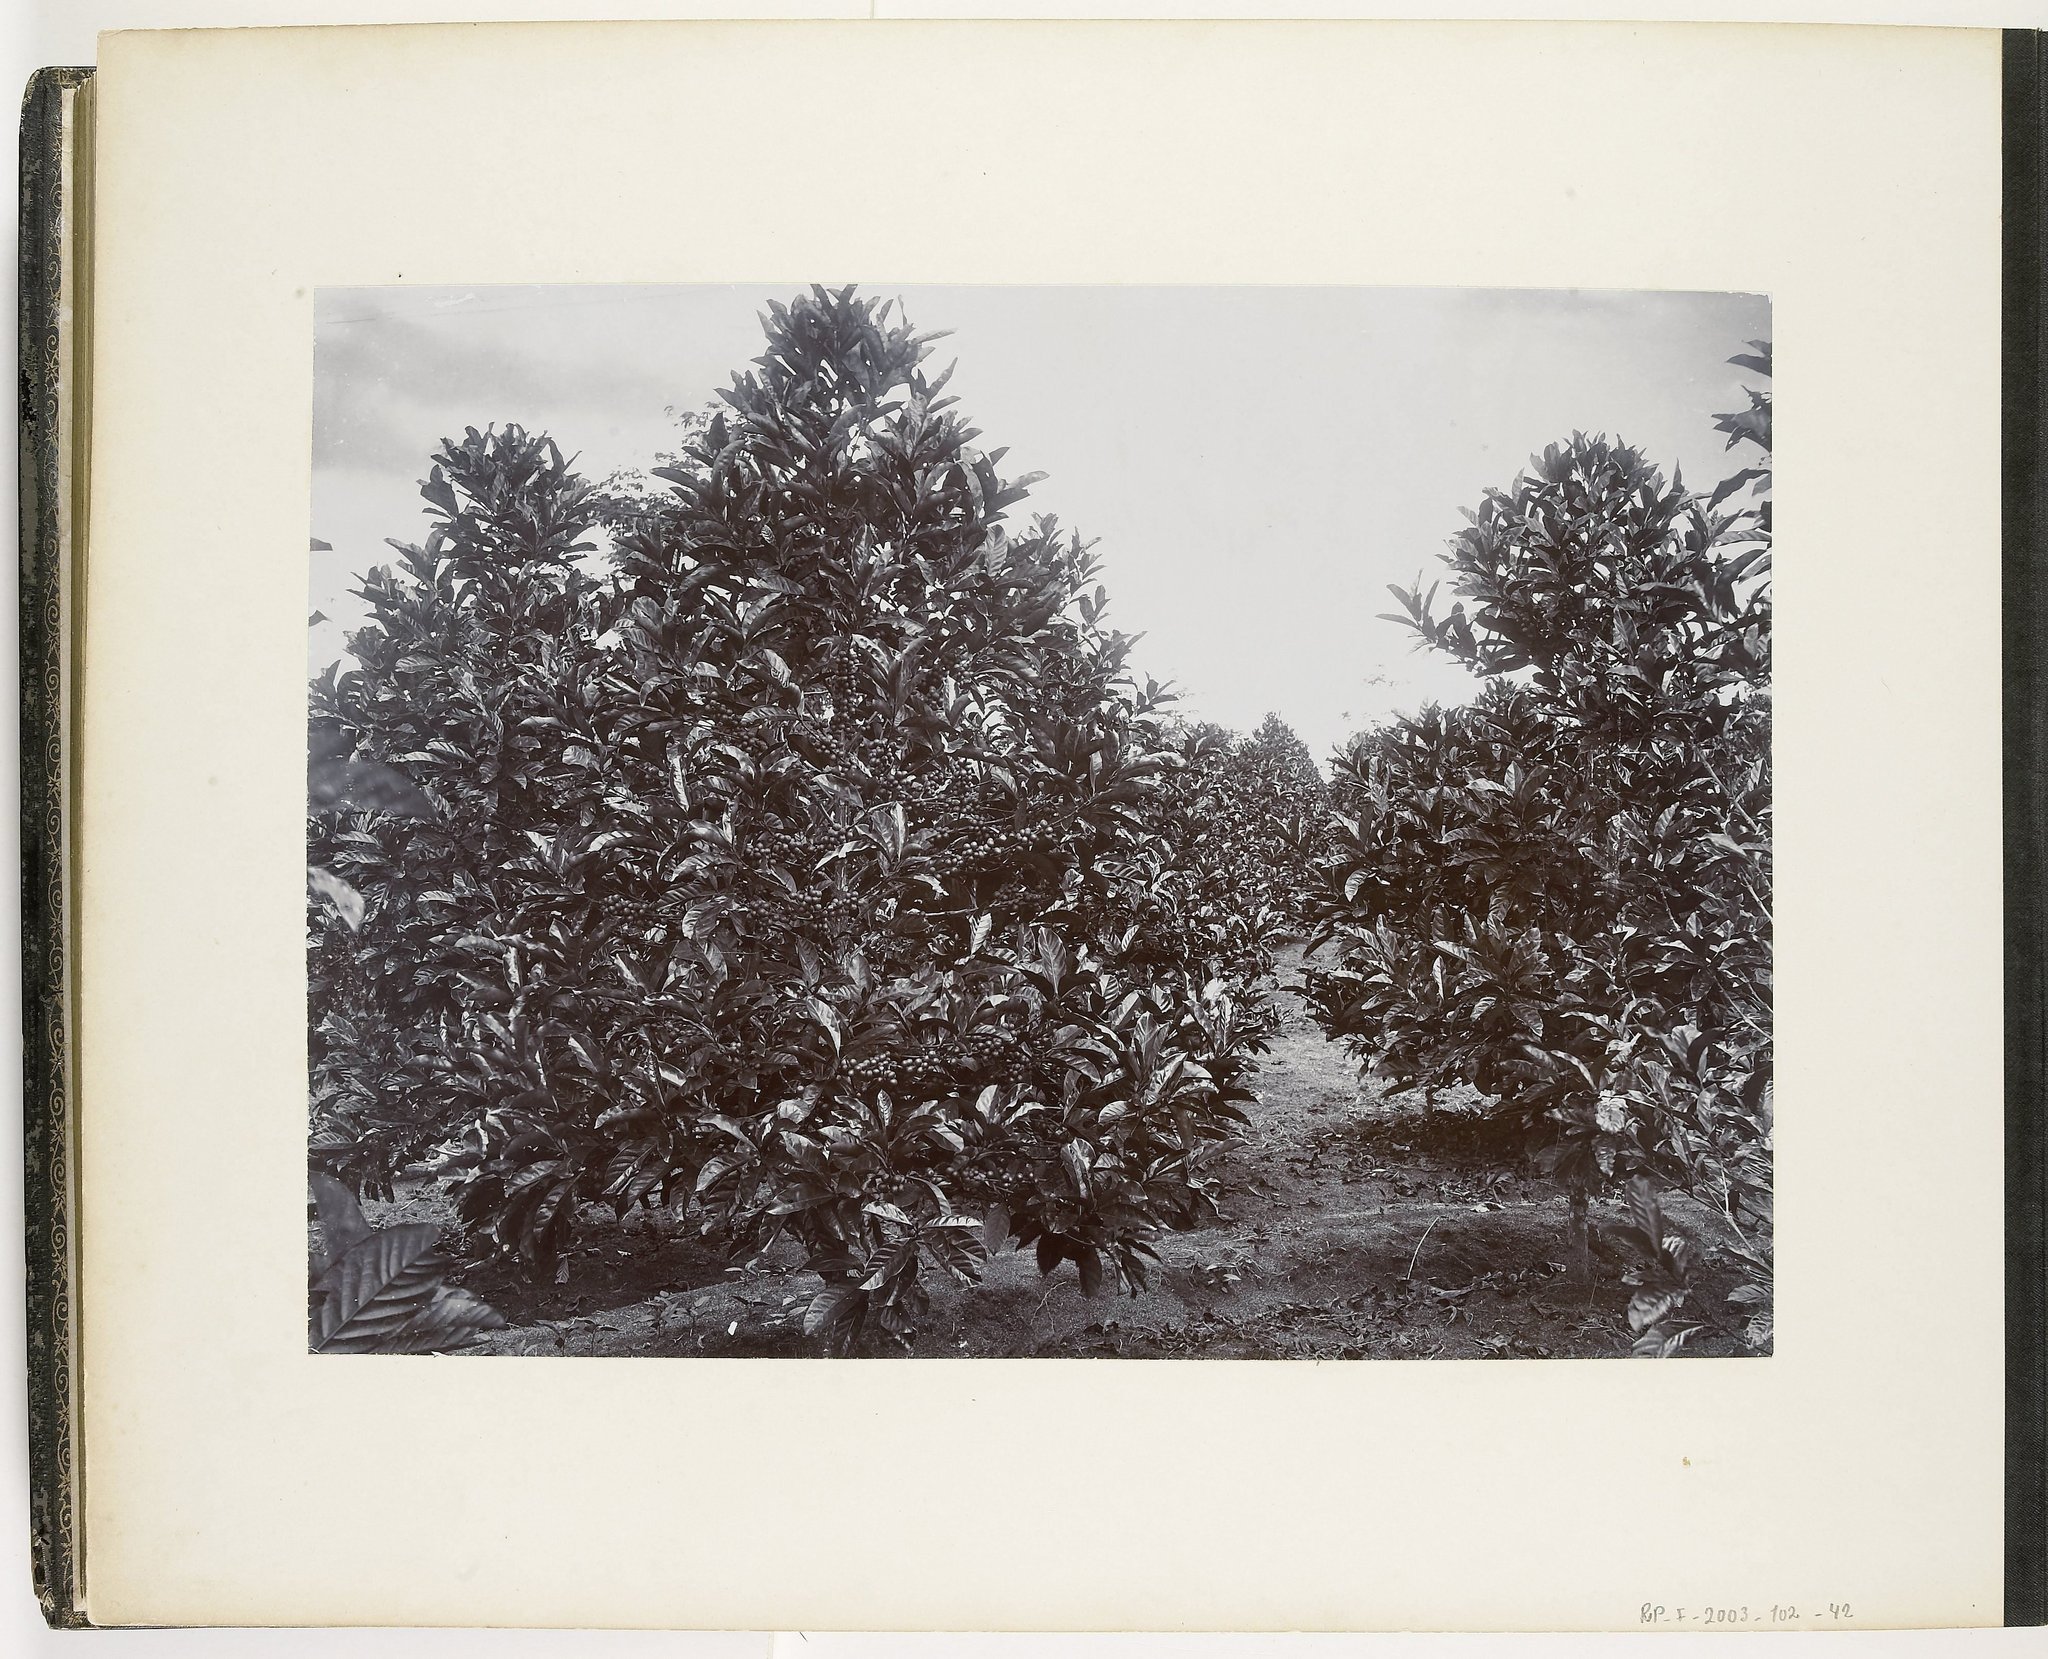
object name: photograph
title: Koffiebomen met vrucht, Sumatra (reifer Kaffee)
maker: carl j. kleingrothe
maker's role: fotograaf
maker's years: 1864-1925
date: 1885-1900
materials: photographic support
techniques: collodion silver print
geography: sumatra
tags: sumatra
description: Gezicht op een veld met koffiebomen met vruchten (vermoedelijk te Bandar Kwalla op landbouwonderneming Bandar Koeala in Serdang in de Oostkust van Sumatra). Onderdeel van het Sumatra fotoalbum van Paul en Lucie Sandel uit 1900.